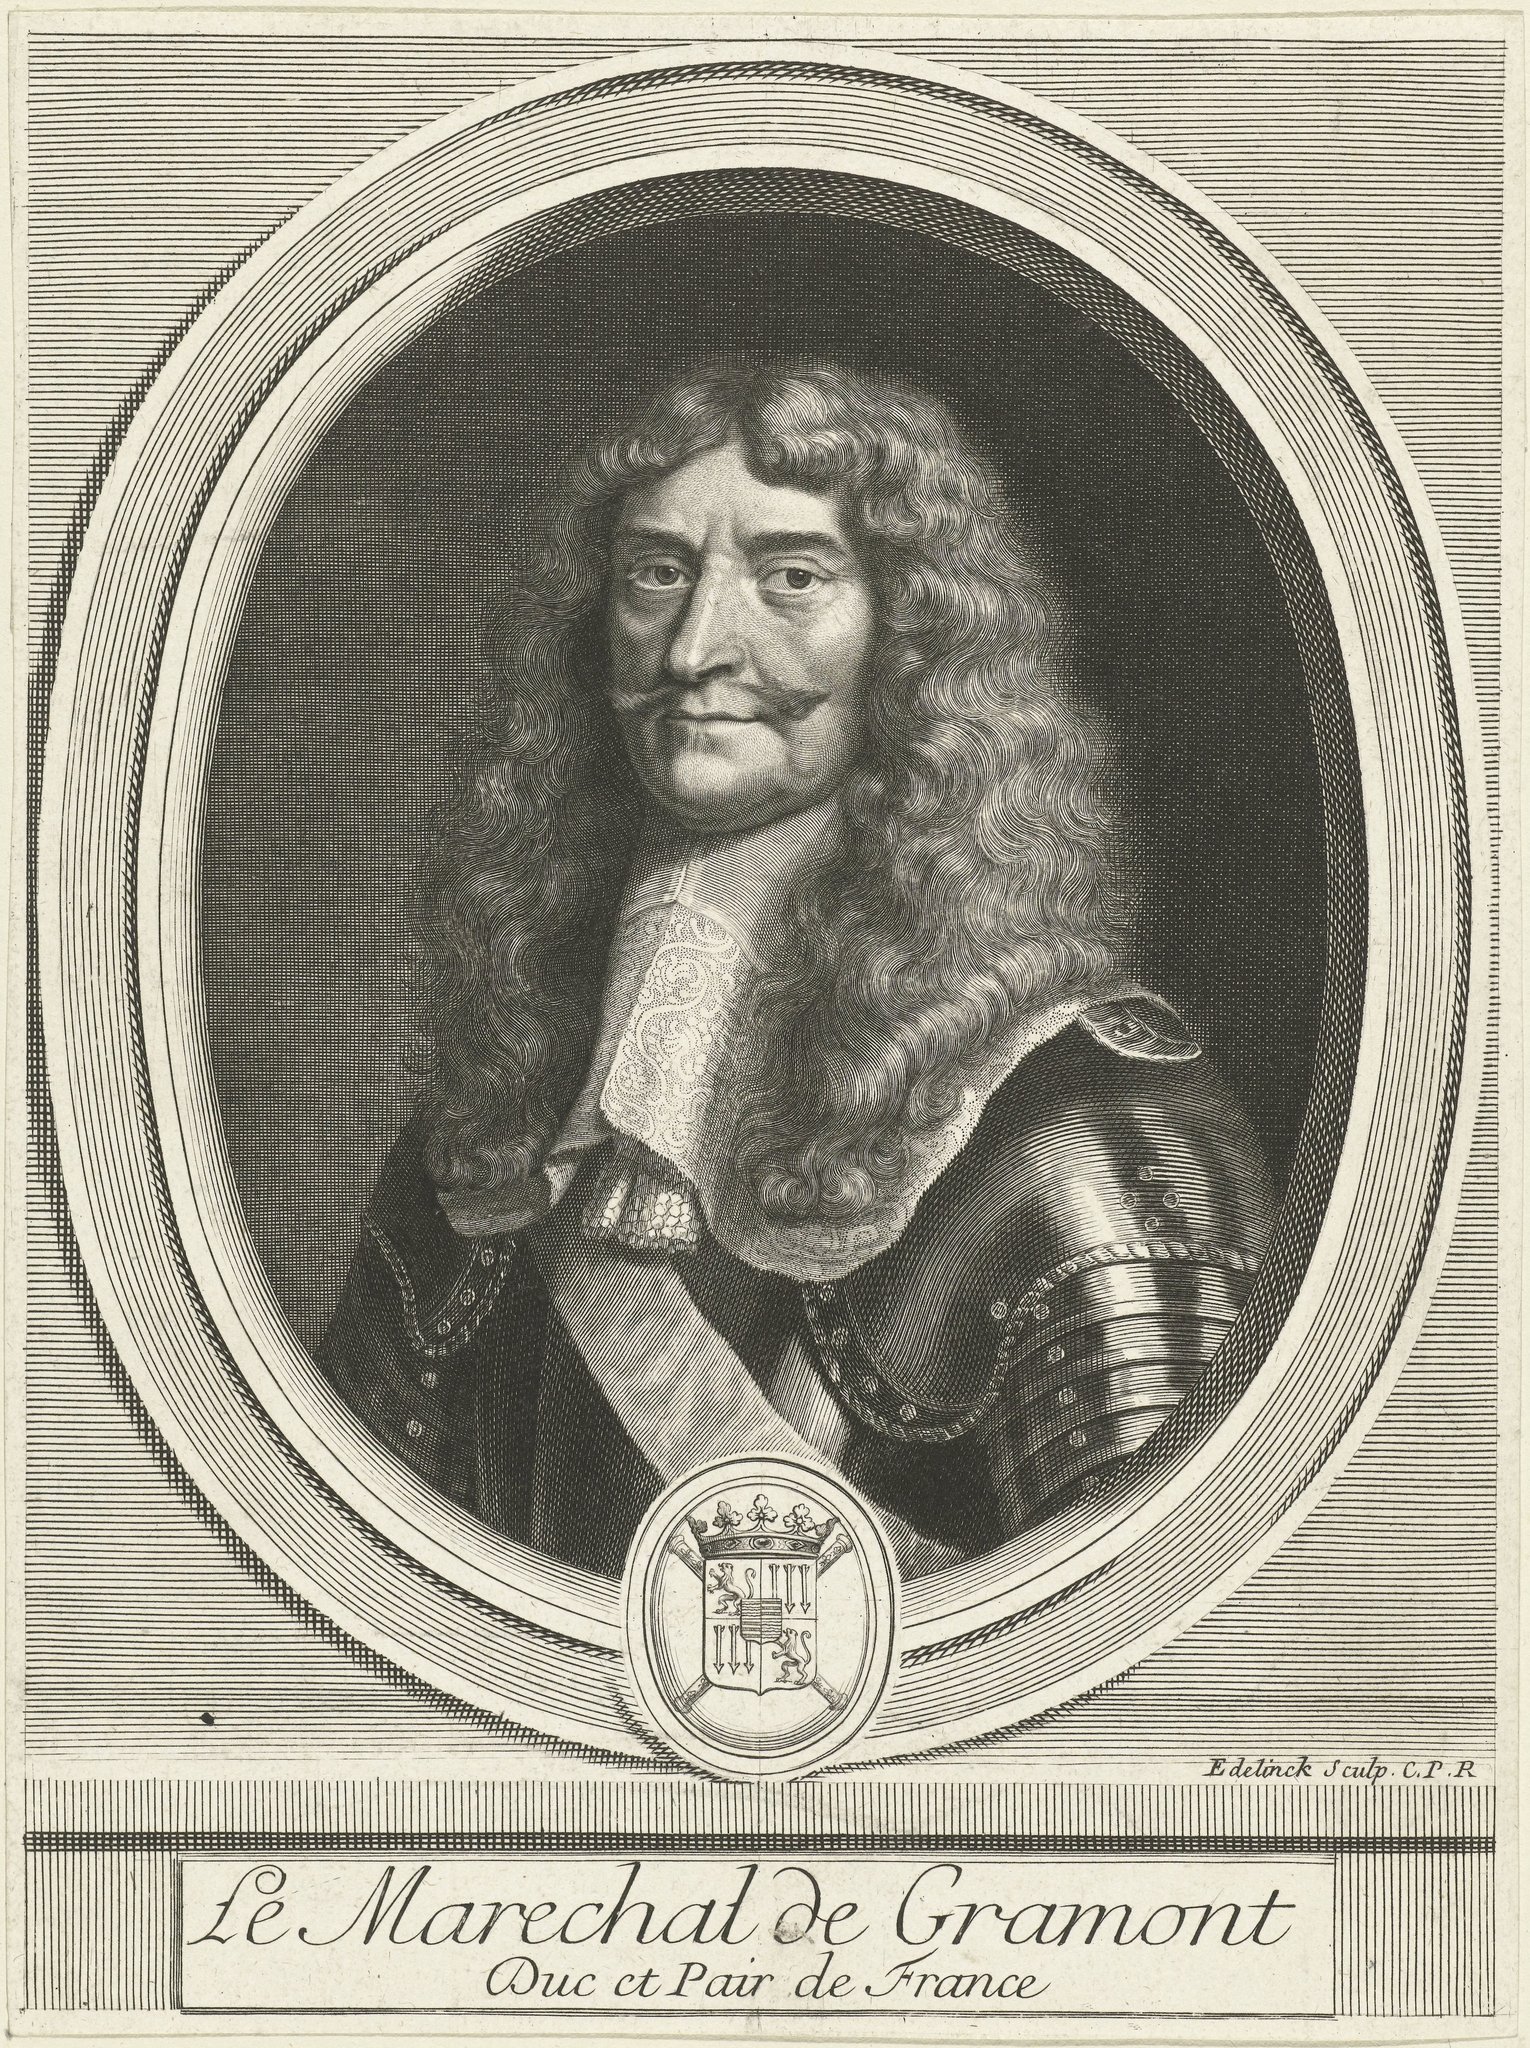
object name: print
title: Portret van Antoine III de Gramont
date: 1666-1707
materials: paper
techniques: engraving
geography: france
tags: france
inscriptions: collector's mark: Lugt 240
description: Portret van de Franse maarschalk Antoine III de Gramont-Toulongeon (1604-1678), hertog van Gramont. Afgebeeld in ovale omlijsting met wapen.